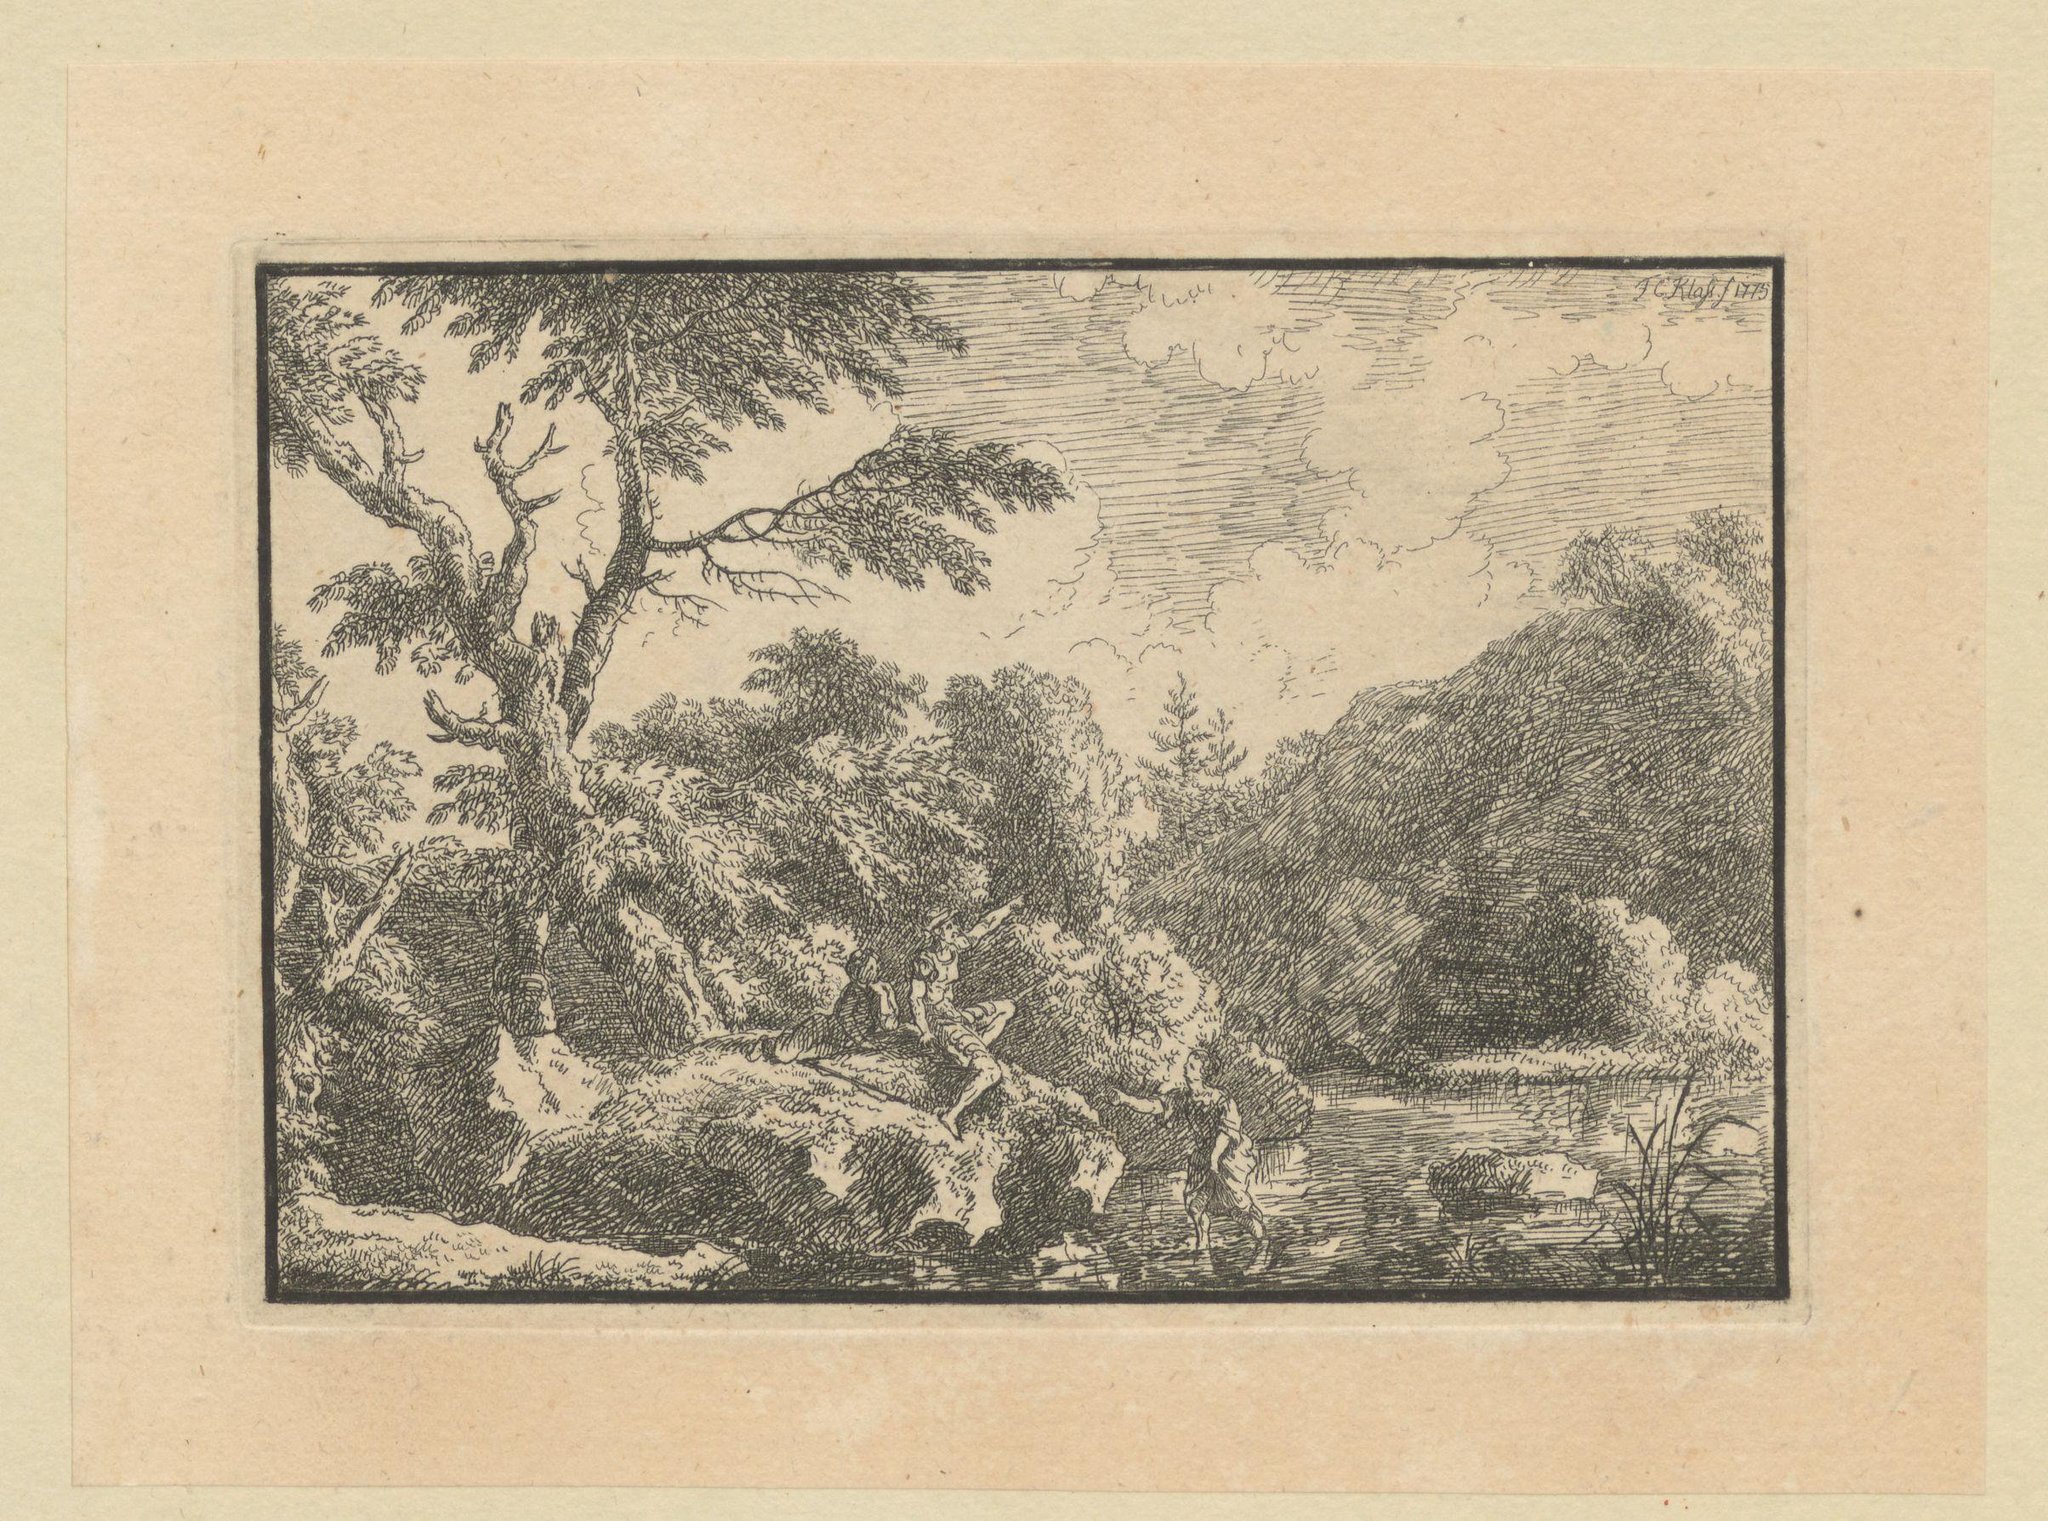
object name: print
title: Landschap met een figuur wadend door water en twee rustend op een rots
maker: friedrich christian klass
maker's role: painter, print maker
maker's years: 1752-1827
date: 1775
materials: paper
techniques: etching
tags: low hill country, (traveller) resting in the open air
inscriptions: collector's mark: Lugt 240